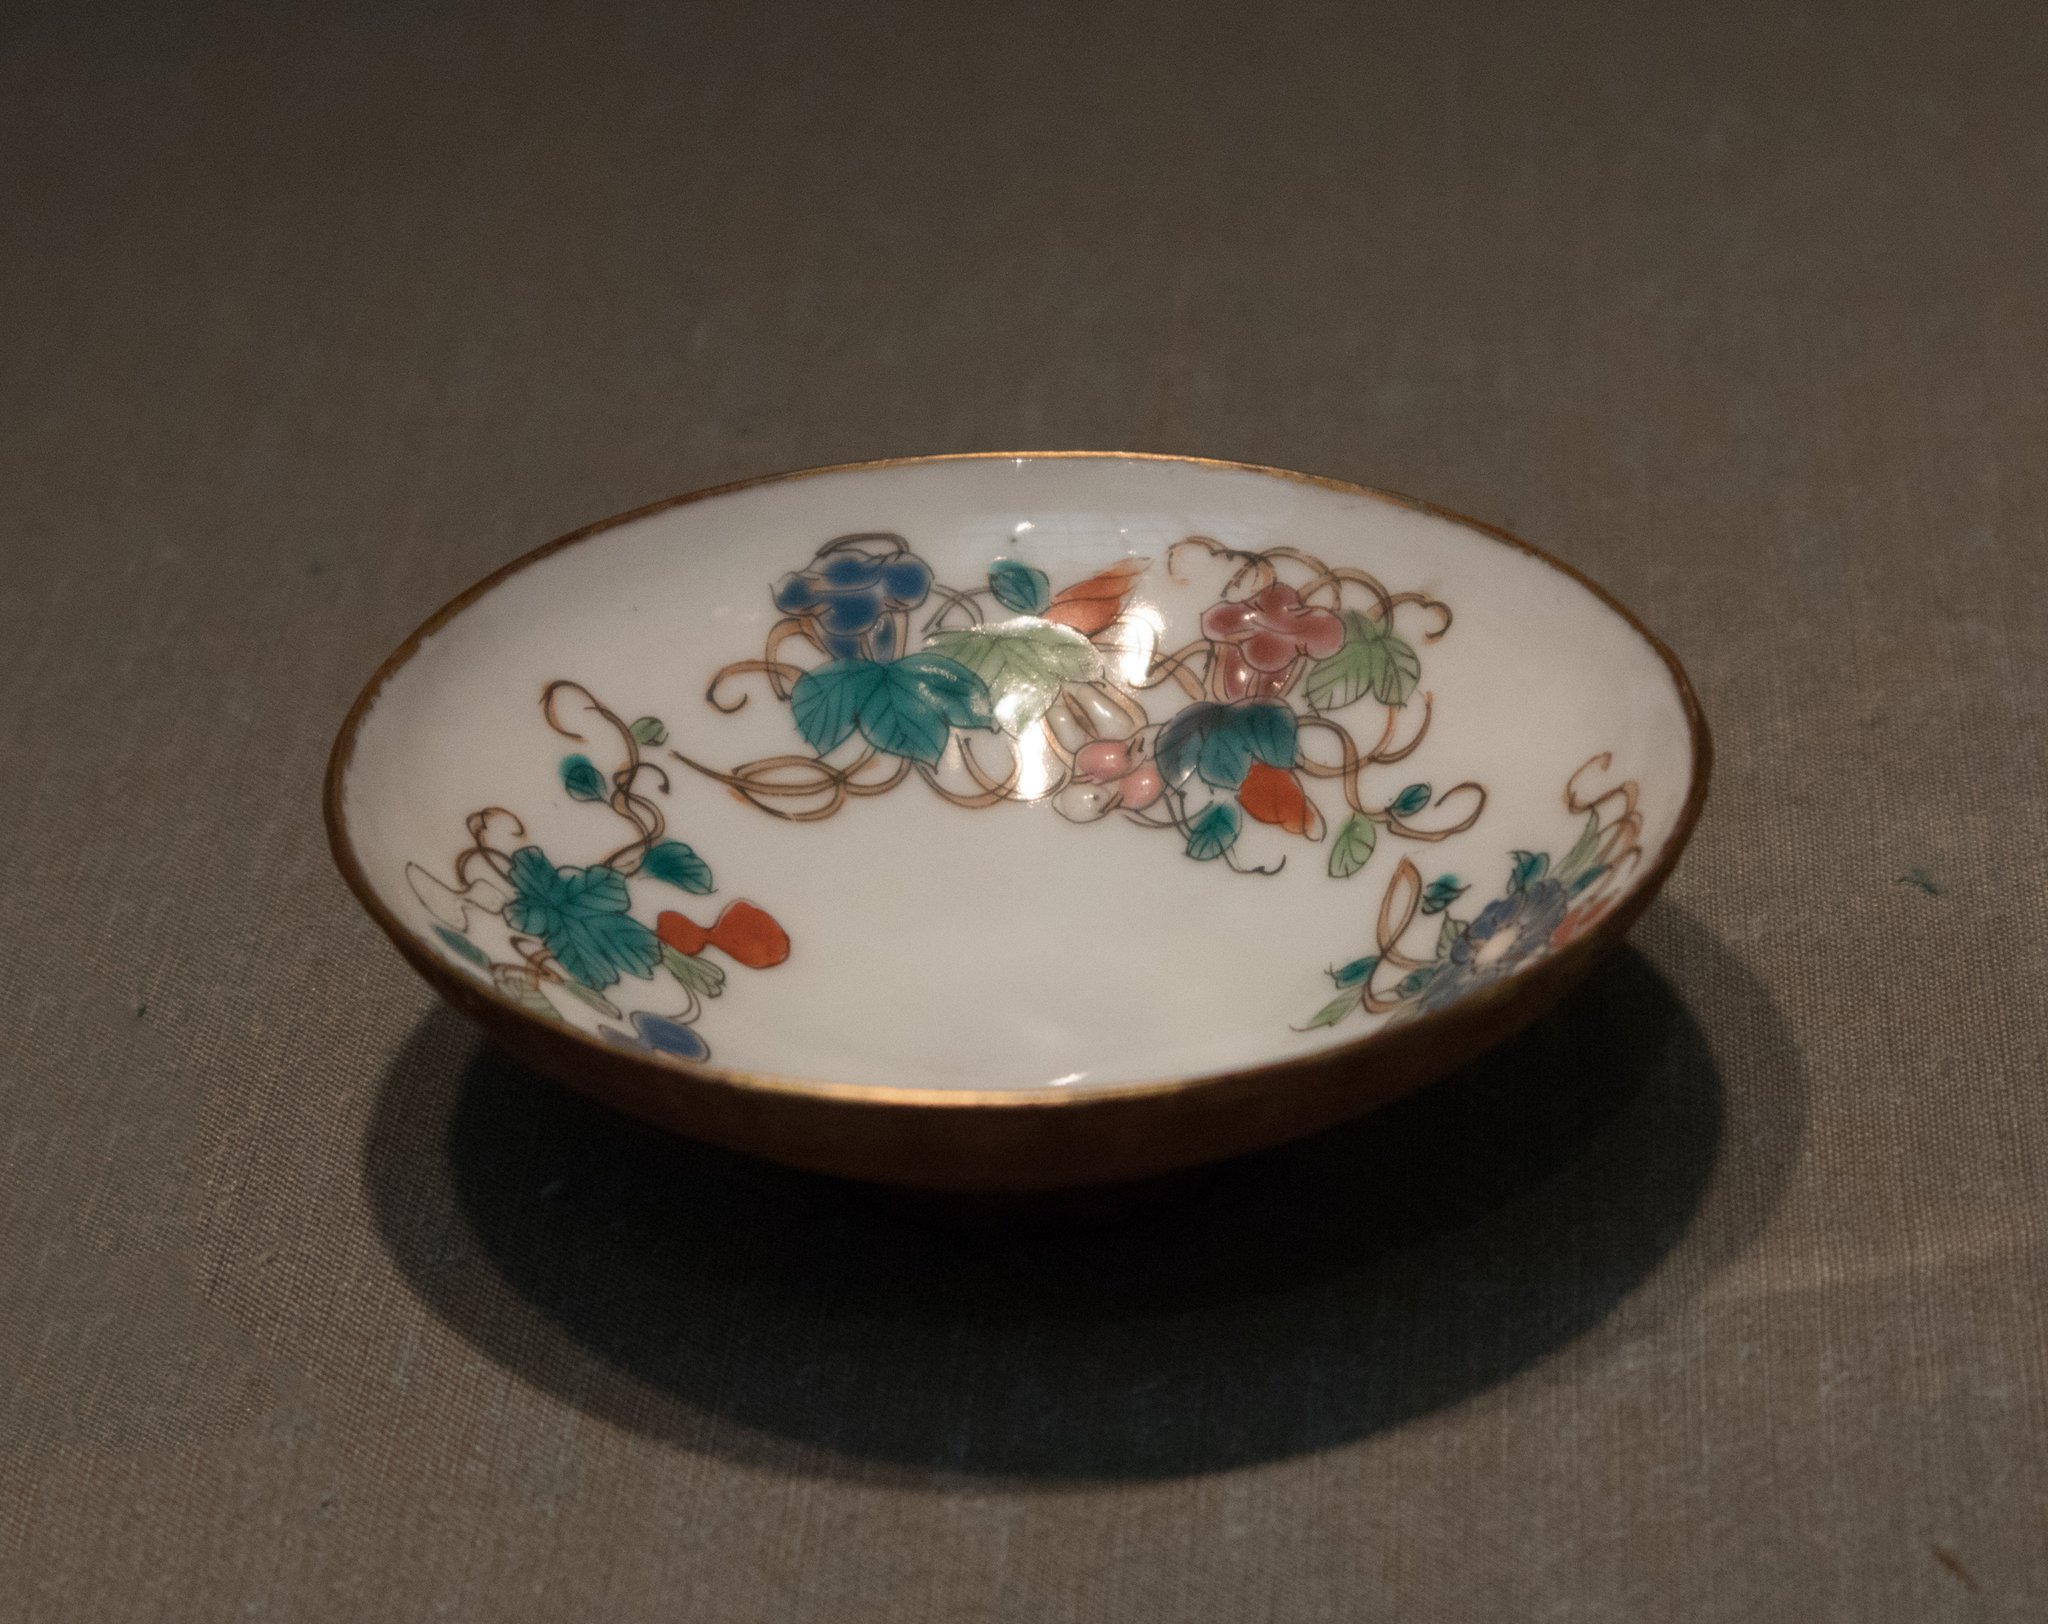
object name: saucer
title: Saucer with Floral Design and Basketry Exterior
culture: japanese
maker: zōshuntei sanpo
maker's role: artist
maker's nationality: japanese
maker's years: 1841-1878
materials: enamel, glaze, porcelain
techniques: painting, polychrome